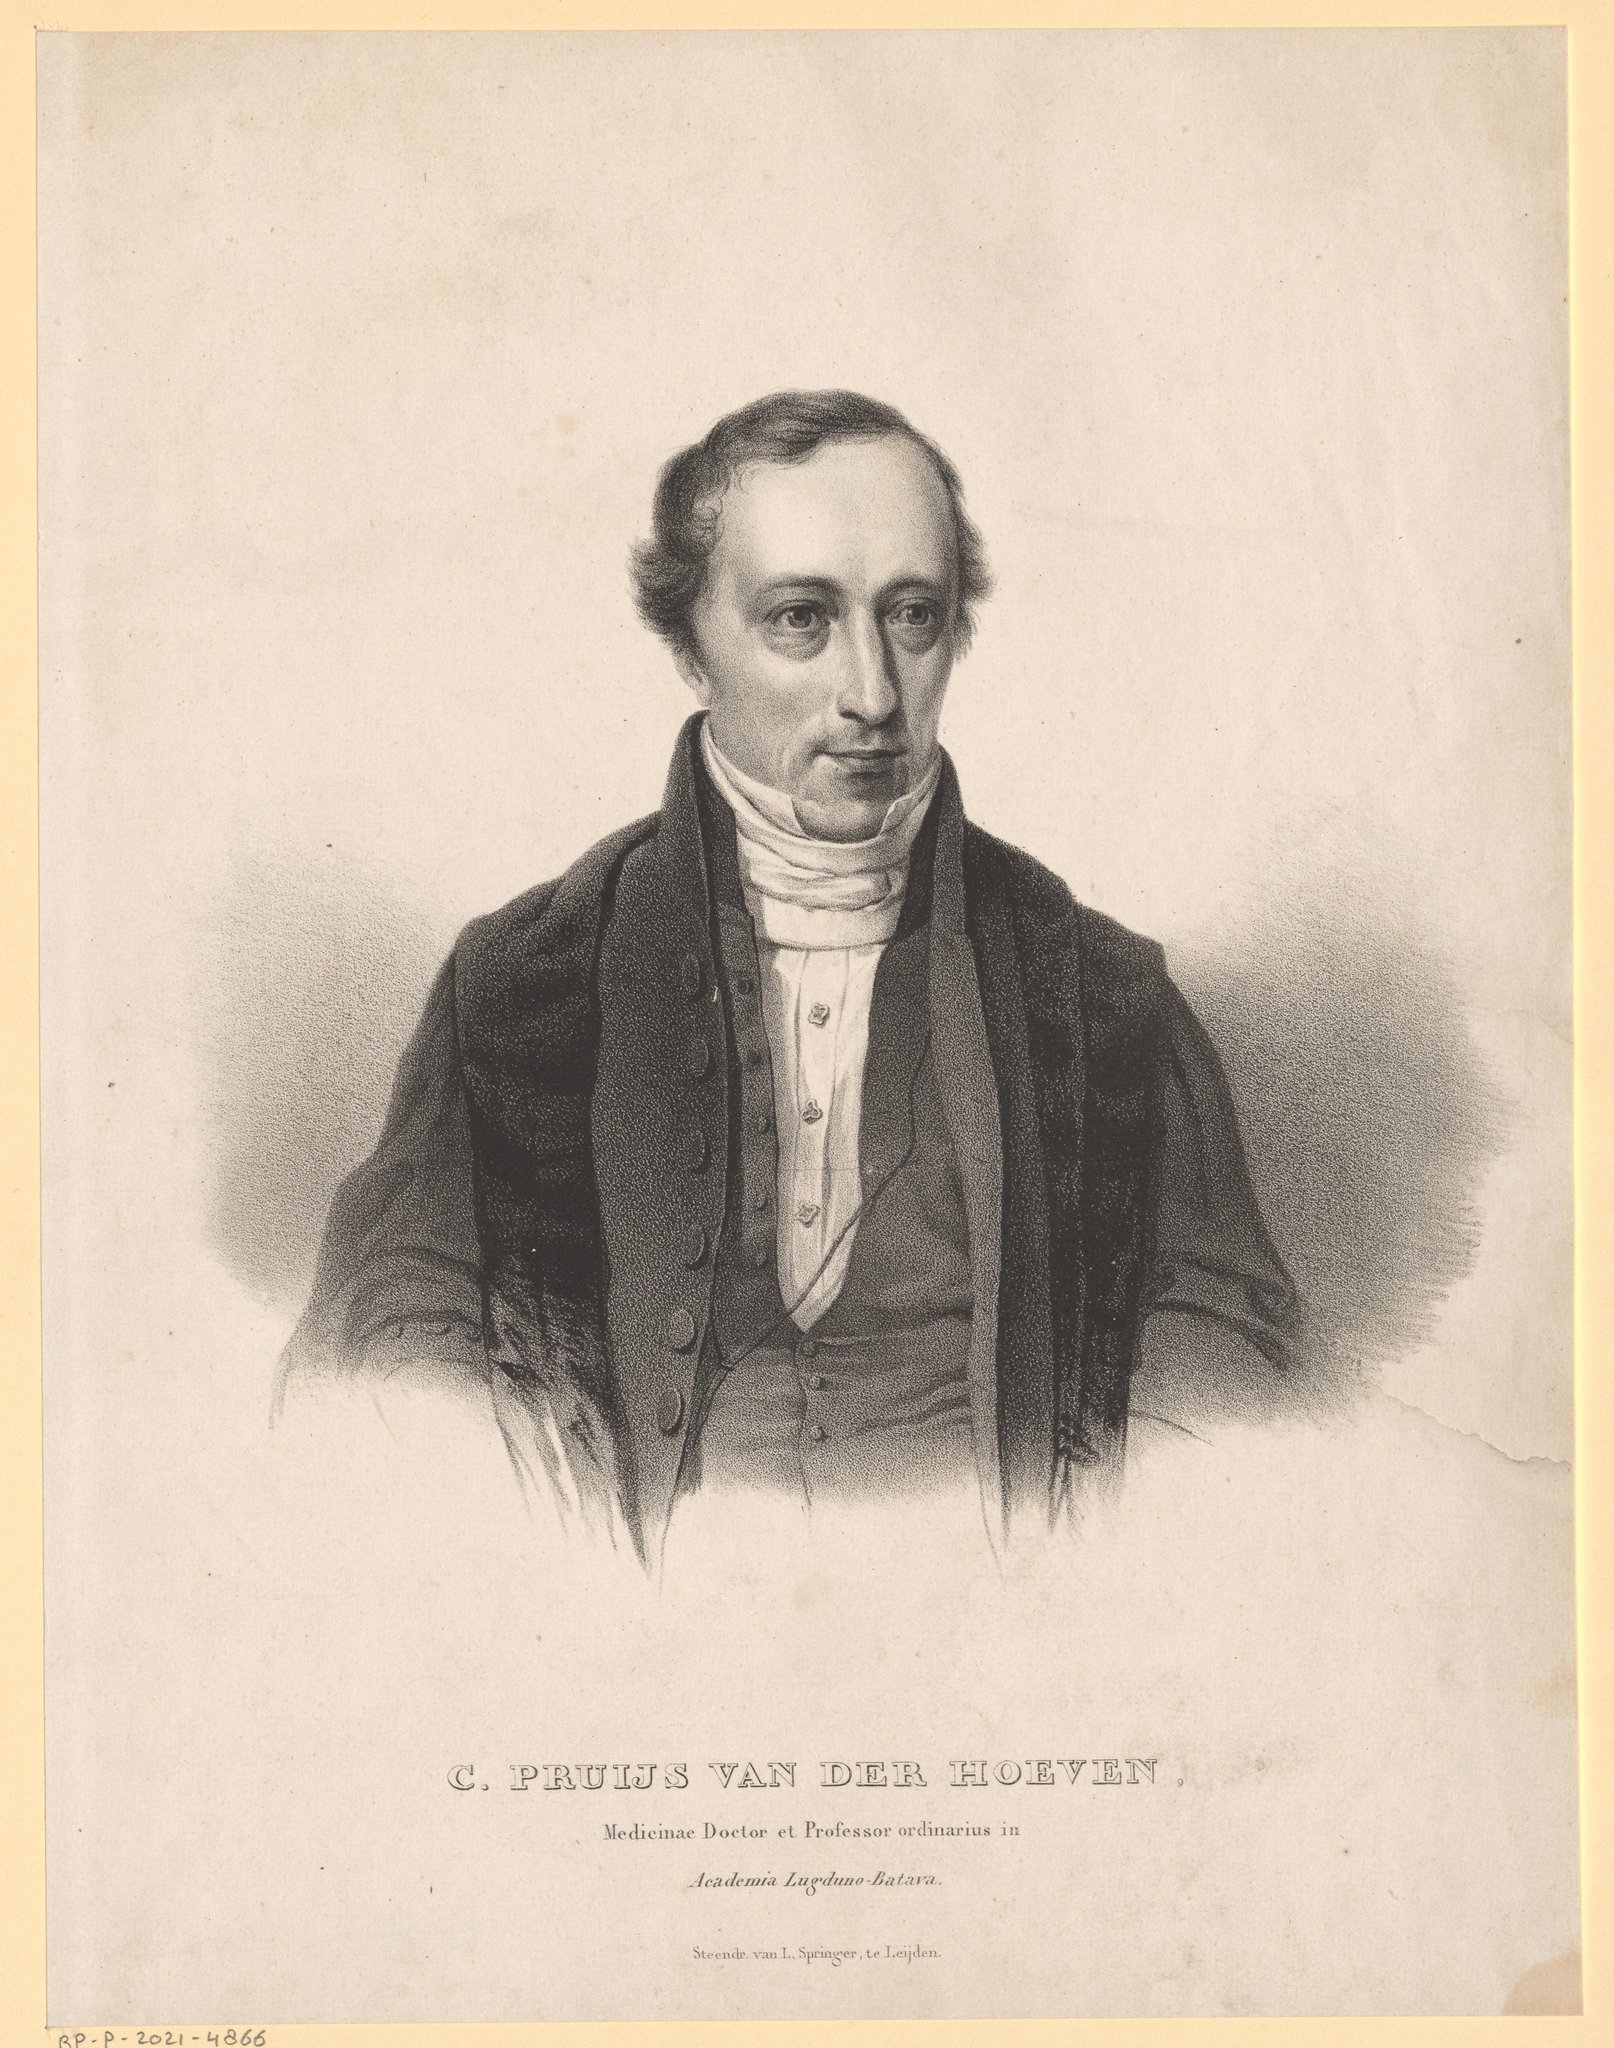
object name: print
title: Portret van Cornelis Pruijs van der Hoeven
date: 1824-1853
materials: paper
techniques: lithograph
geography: leiden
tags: leiden, historical persons, physician, doctor